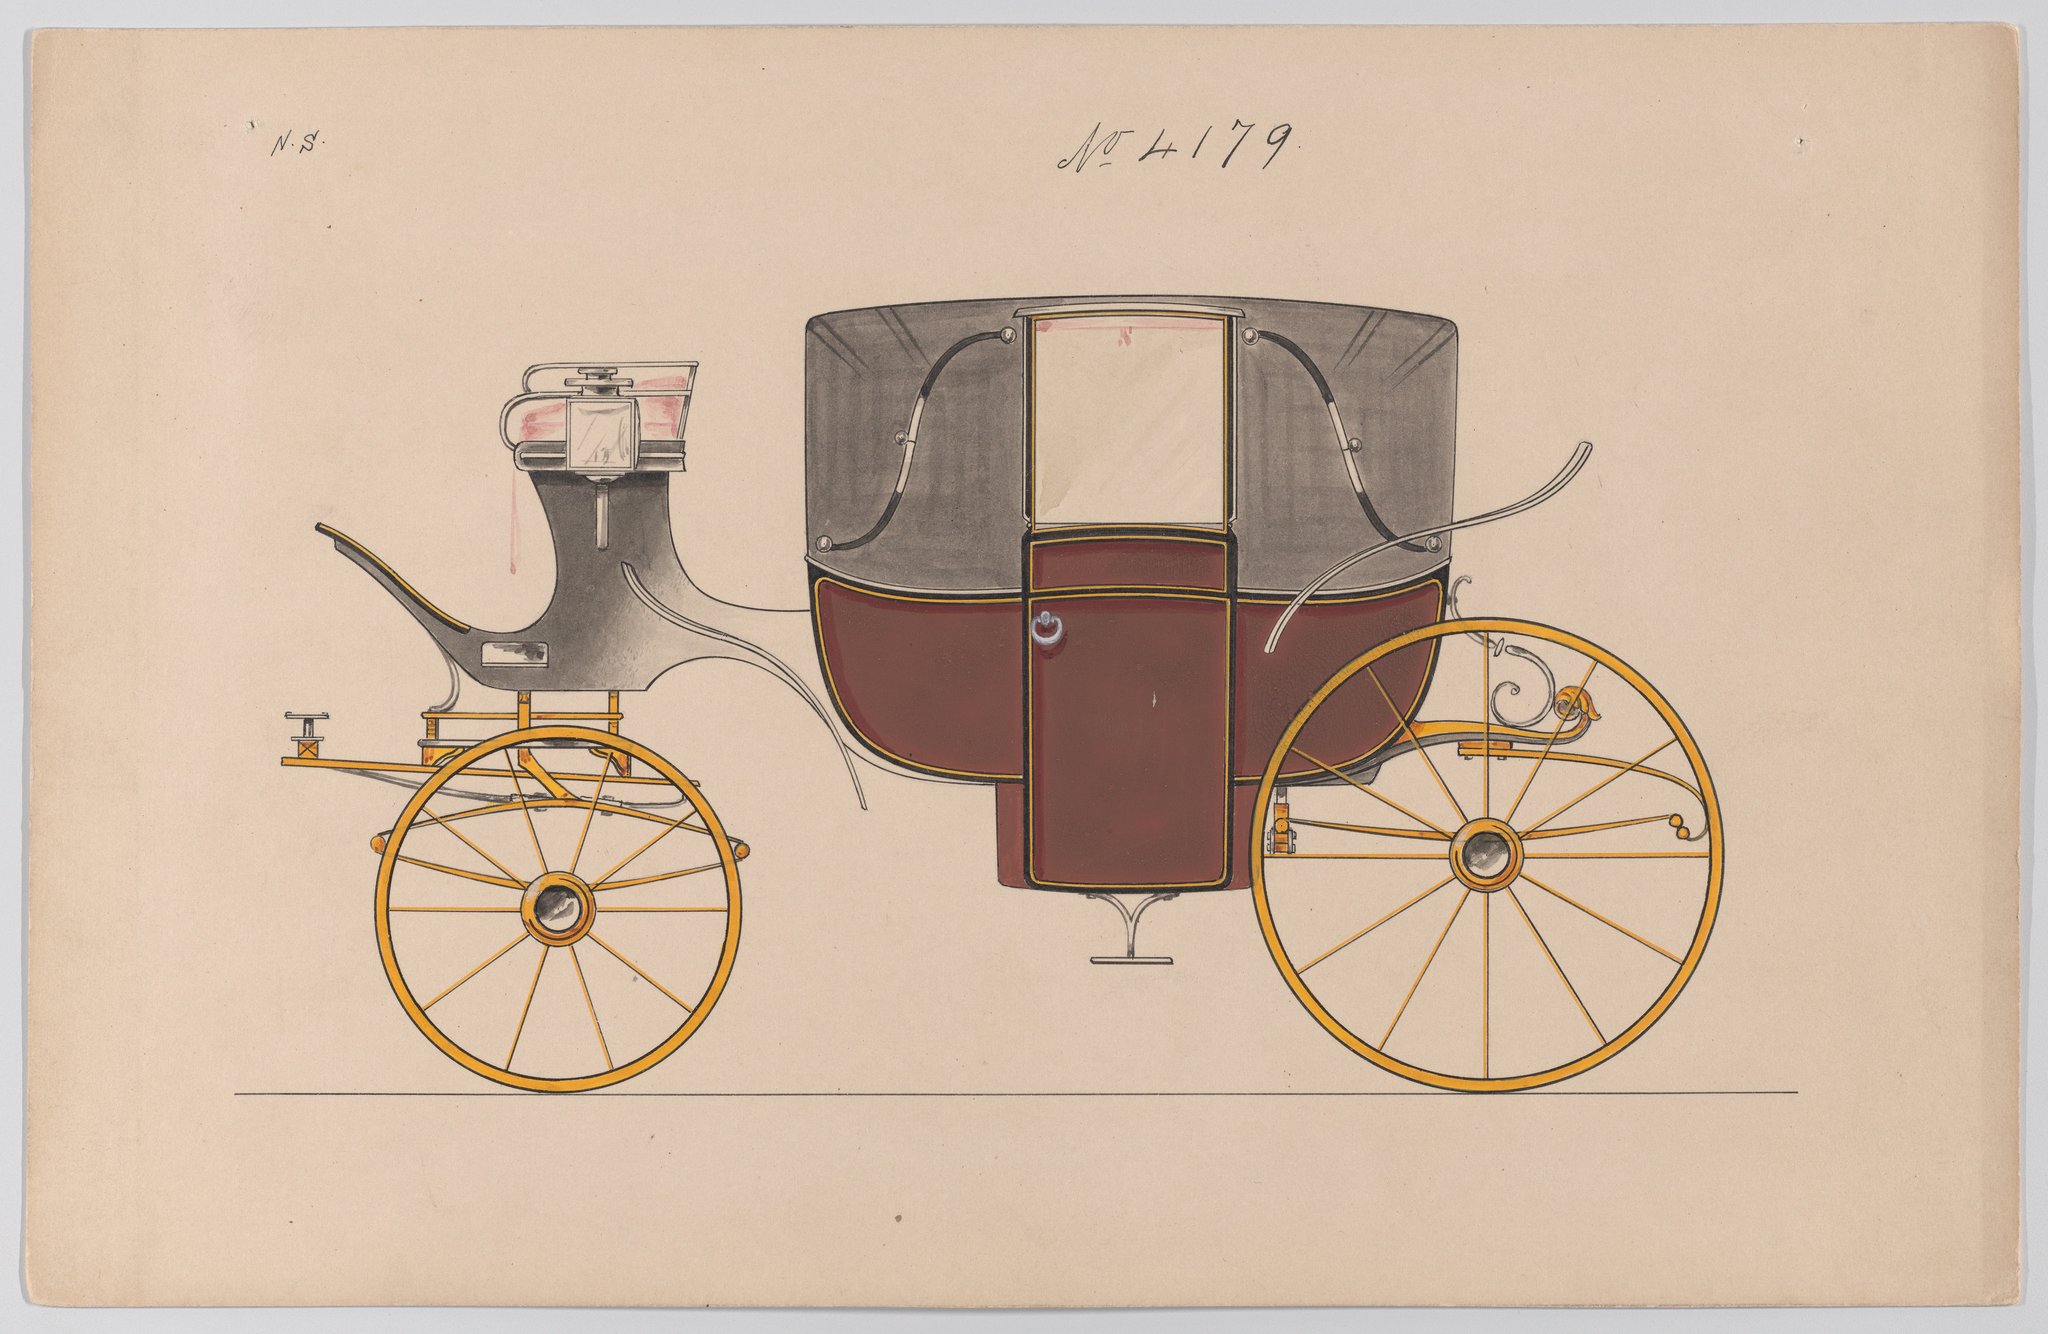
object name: drawing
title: Design for Landau, No. 4179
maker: brewster & co.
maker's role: manufacturer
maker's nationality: american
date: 1892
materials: gouache, gum arabic, ink, watercolor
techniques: pen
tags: carriages